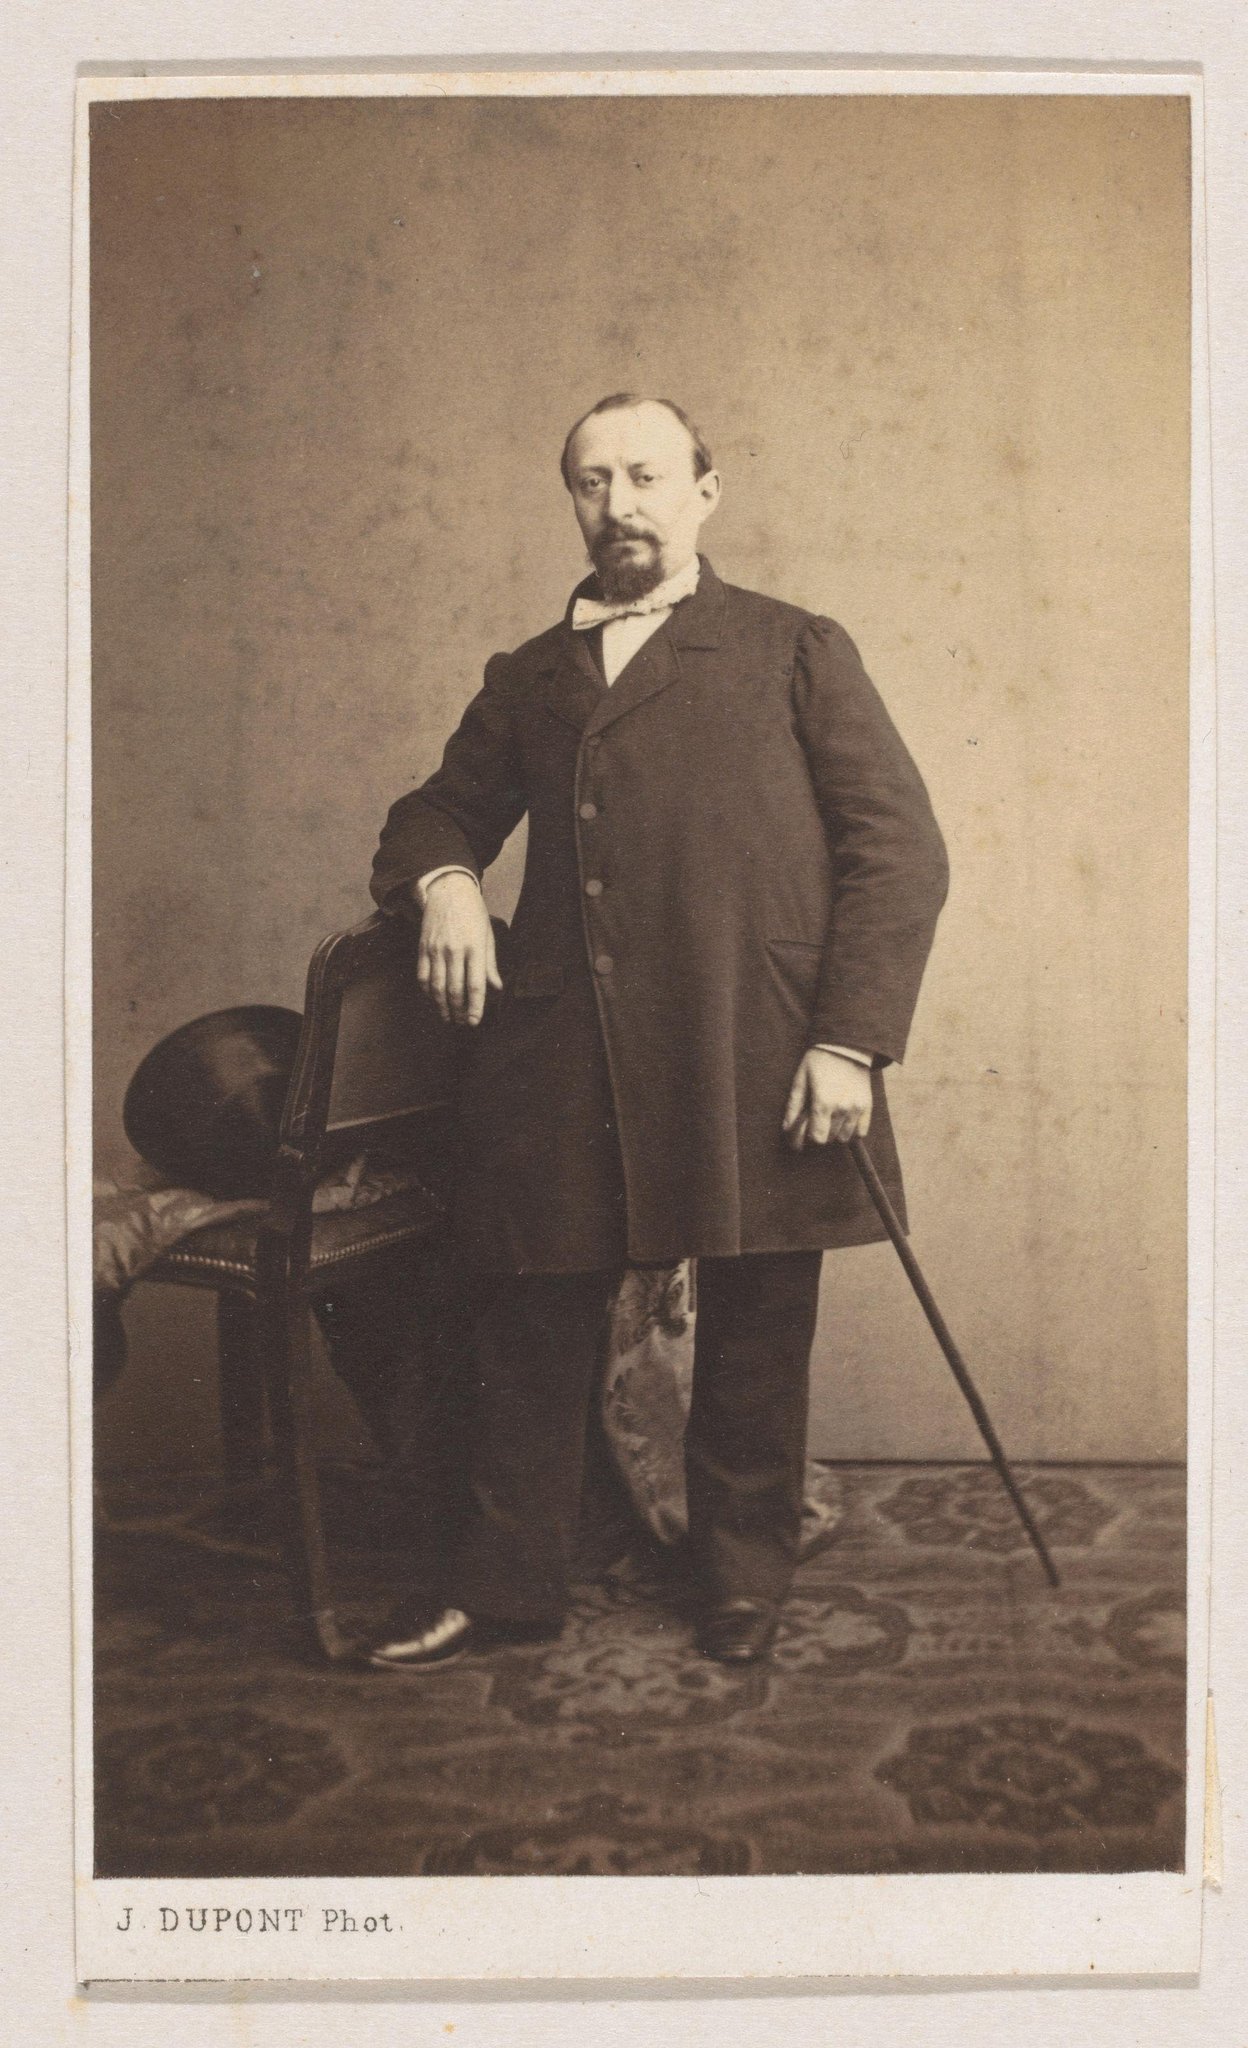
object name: photograph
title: Portret van de schilder Alexandre Pierre Jacques Markelbach, ten voeten uit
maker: joseph dupont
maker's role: fotograaf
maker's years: 1818-1901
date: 1861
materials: cardboard, paper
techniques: albumen print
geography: antwerp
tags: antwerp, painter, alexandre markelbach, historical persons, portrait, self-portrait of painter, portrait, self-portrait of artist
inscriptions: inscription: ‘ETABLISSEMENT PHOTOGRAPHIQUE/ de/ J. DUPONT/ Place de Meir 32/ ANVERS/ Maison fondée en 1853’